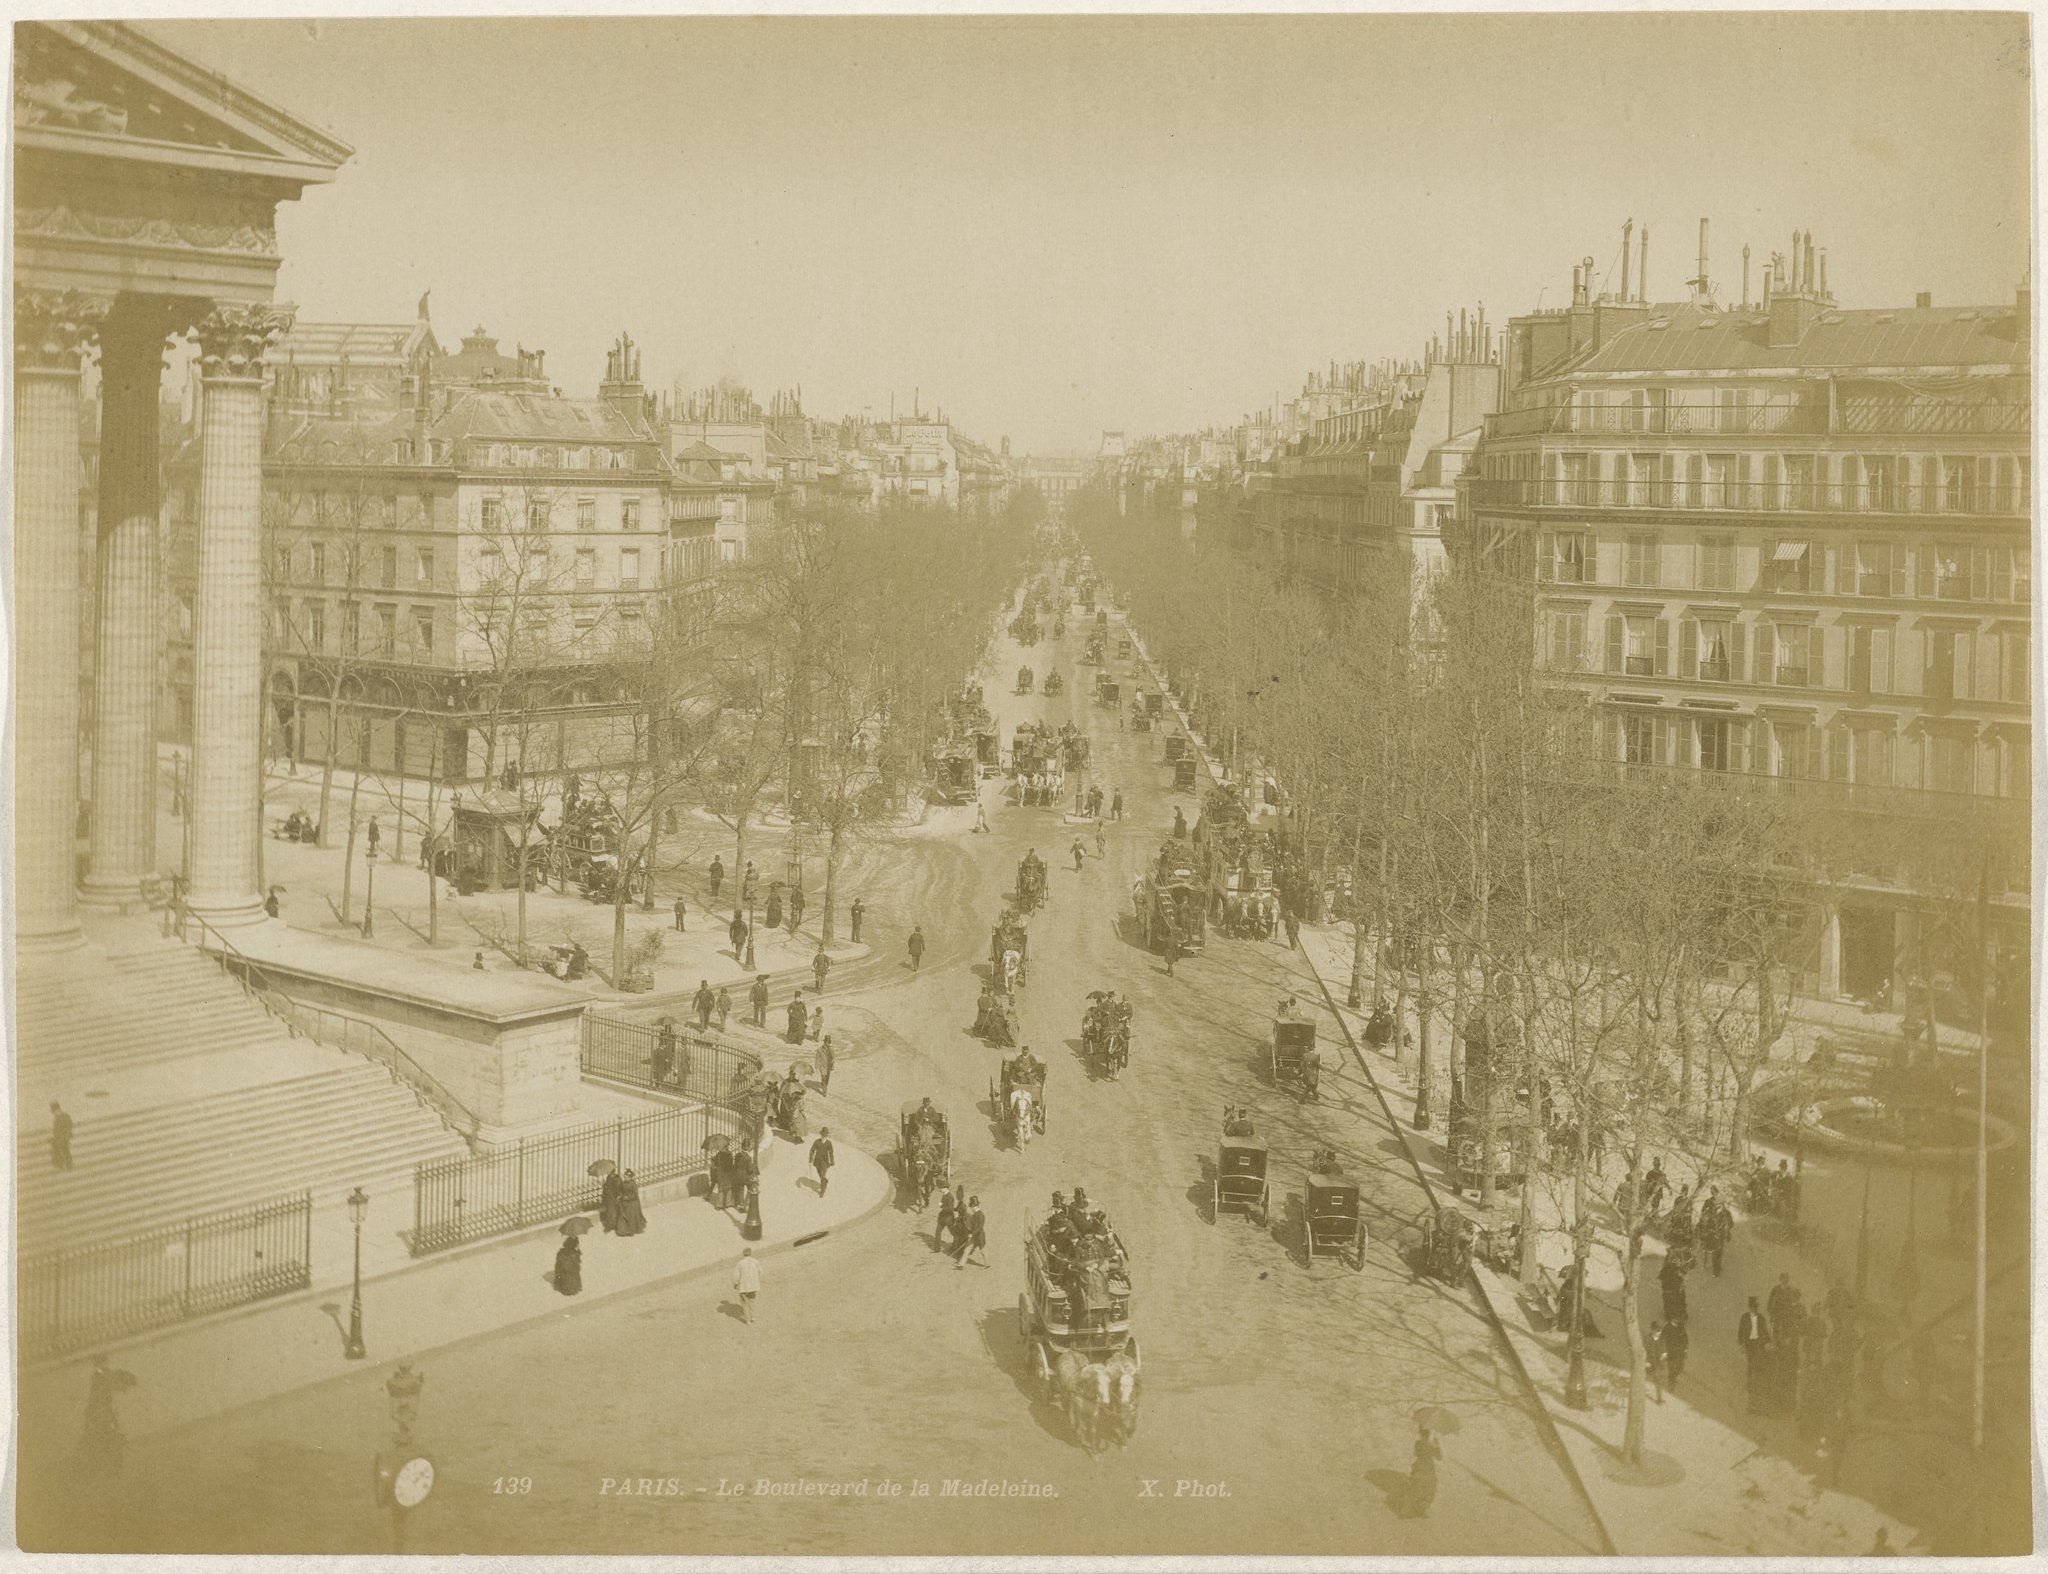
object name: photograph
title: Boulevard de la Madeleine in Parijs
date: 1887-1900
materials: paper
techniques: albumen print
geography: paris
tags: street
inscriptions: number: ‘139’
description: Tussen 1887 en ca. 1900 werkten Neurdein frères onder andere onder de naam 'X phot.'.